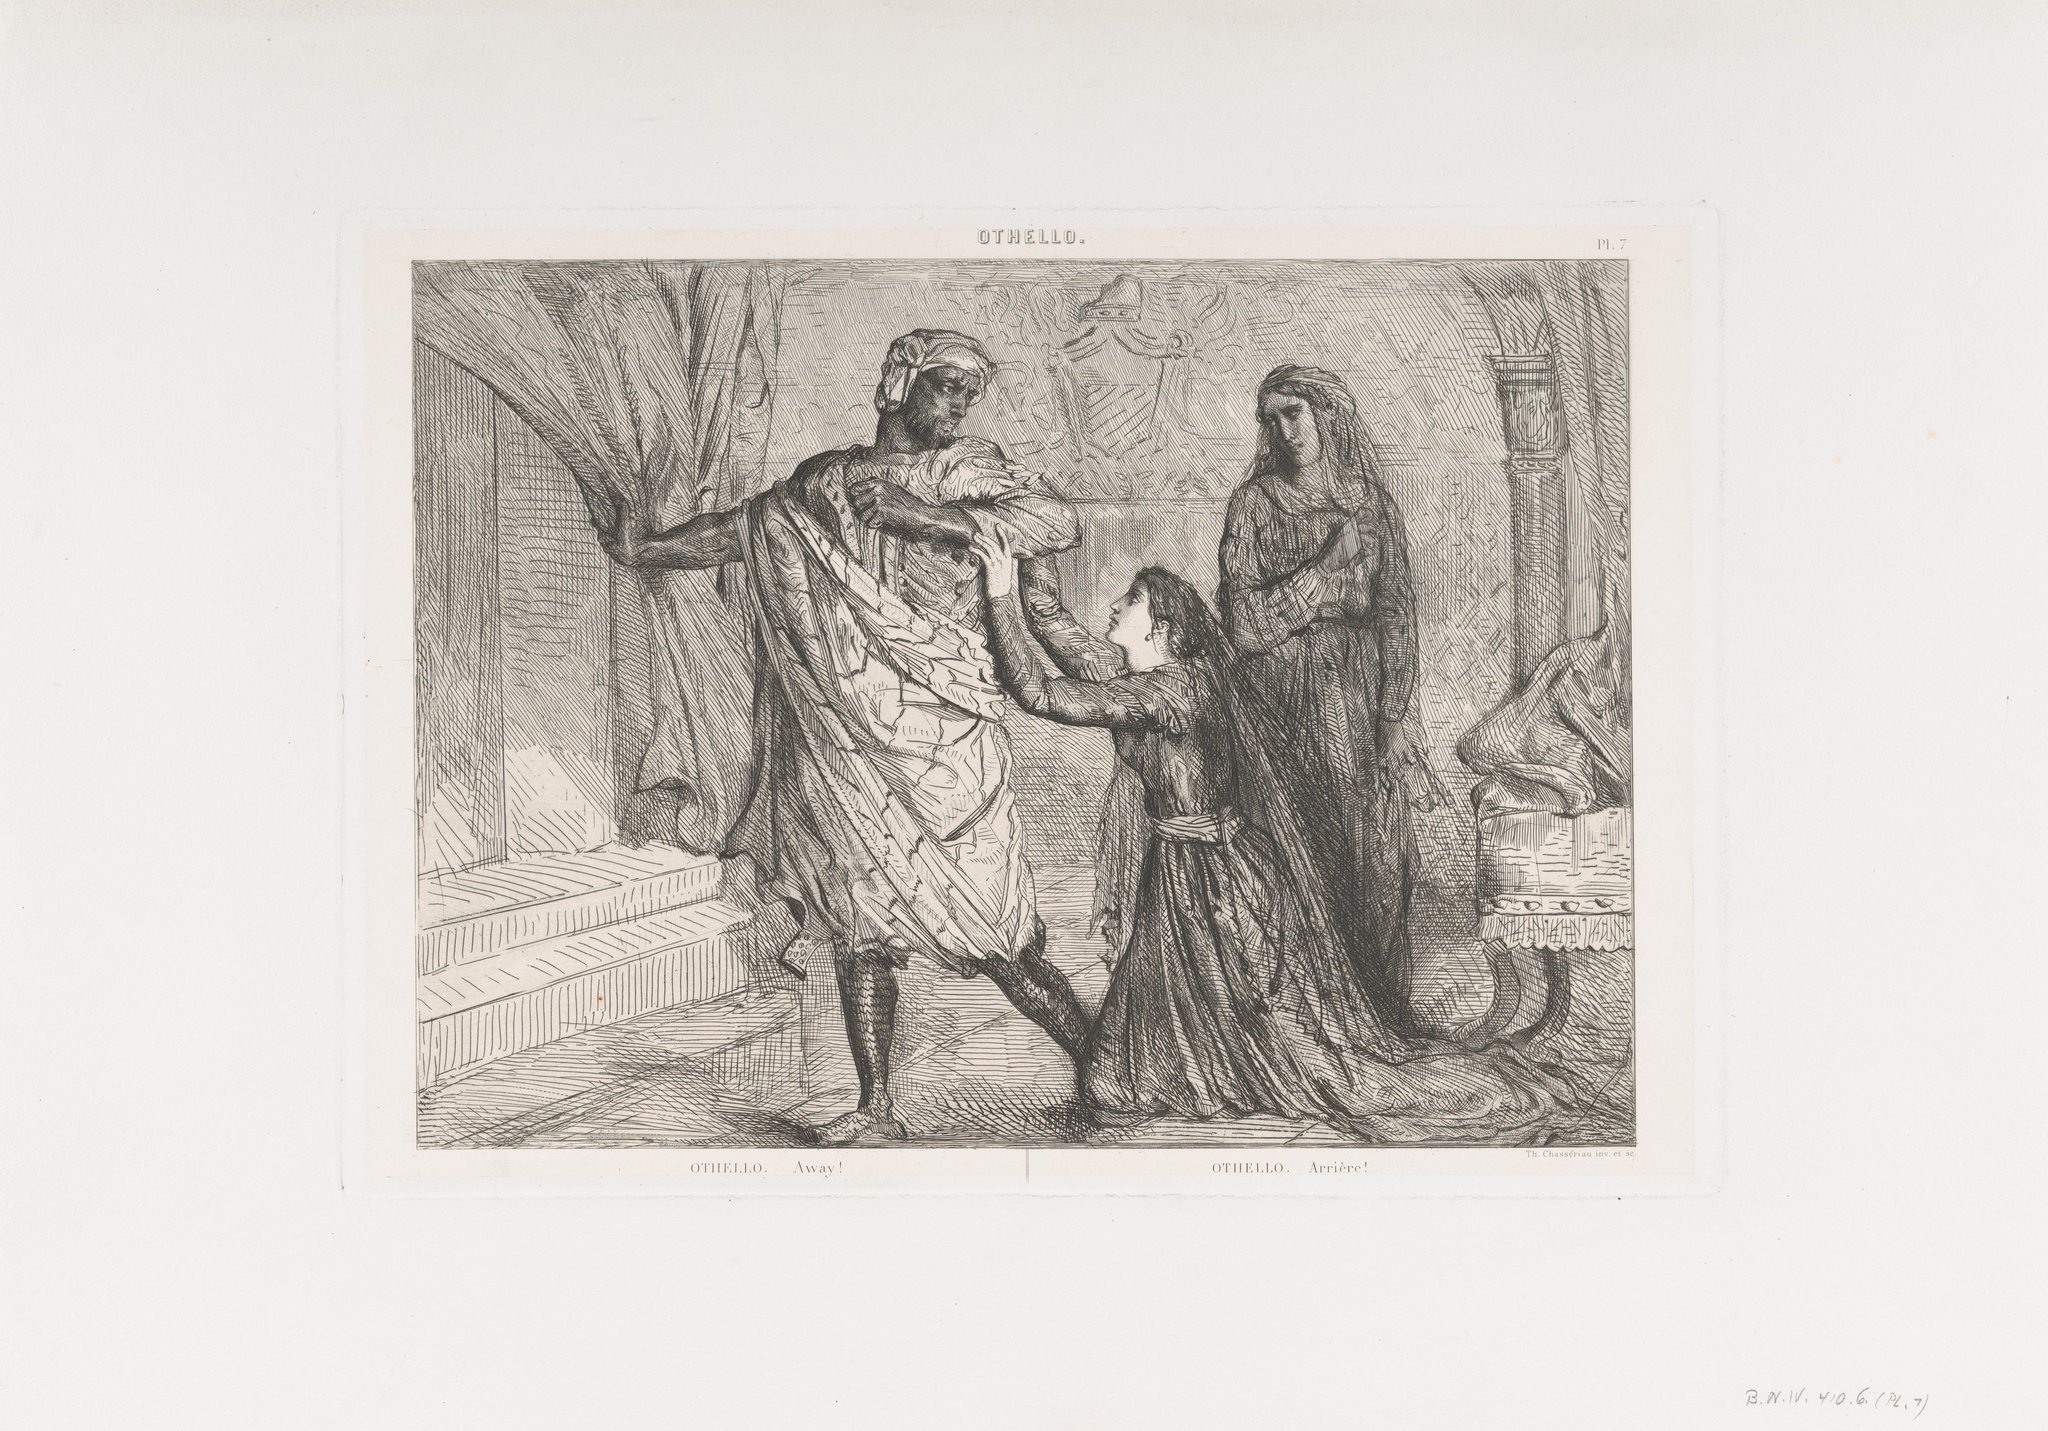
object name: print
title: "Away!": plate 7 from Othello (Act 3, Scene 4)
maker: théodore chassériau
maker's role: artist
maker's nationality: french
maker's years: 1819-1856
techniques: aquatint, printmaking, drypoint, engraving, etching, roulette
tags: shakespeare,men,women